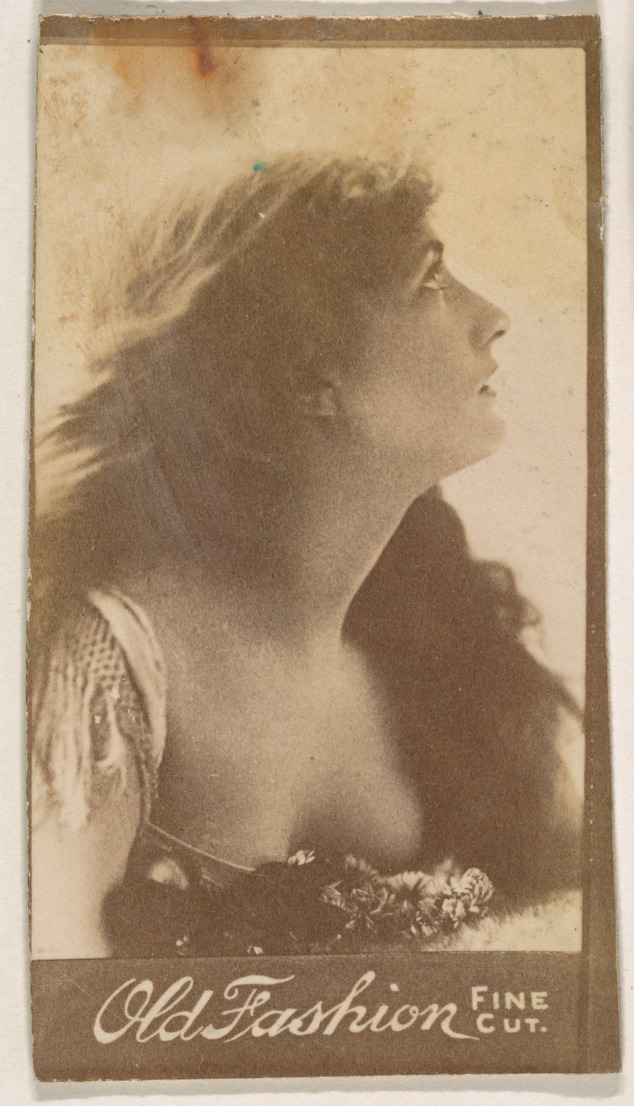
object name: photograph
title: Profile of actress looking up, from the Actresses series (N664) promoting Old Fashion Fine Cut Tobacco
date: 1888-1890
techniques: albumen silver print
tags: portraits,profiles,women,actresses